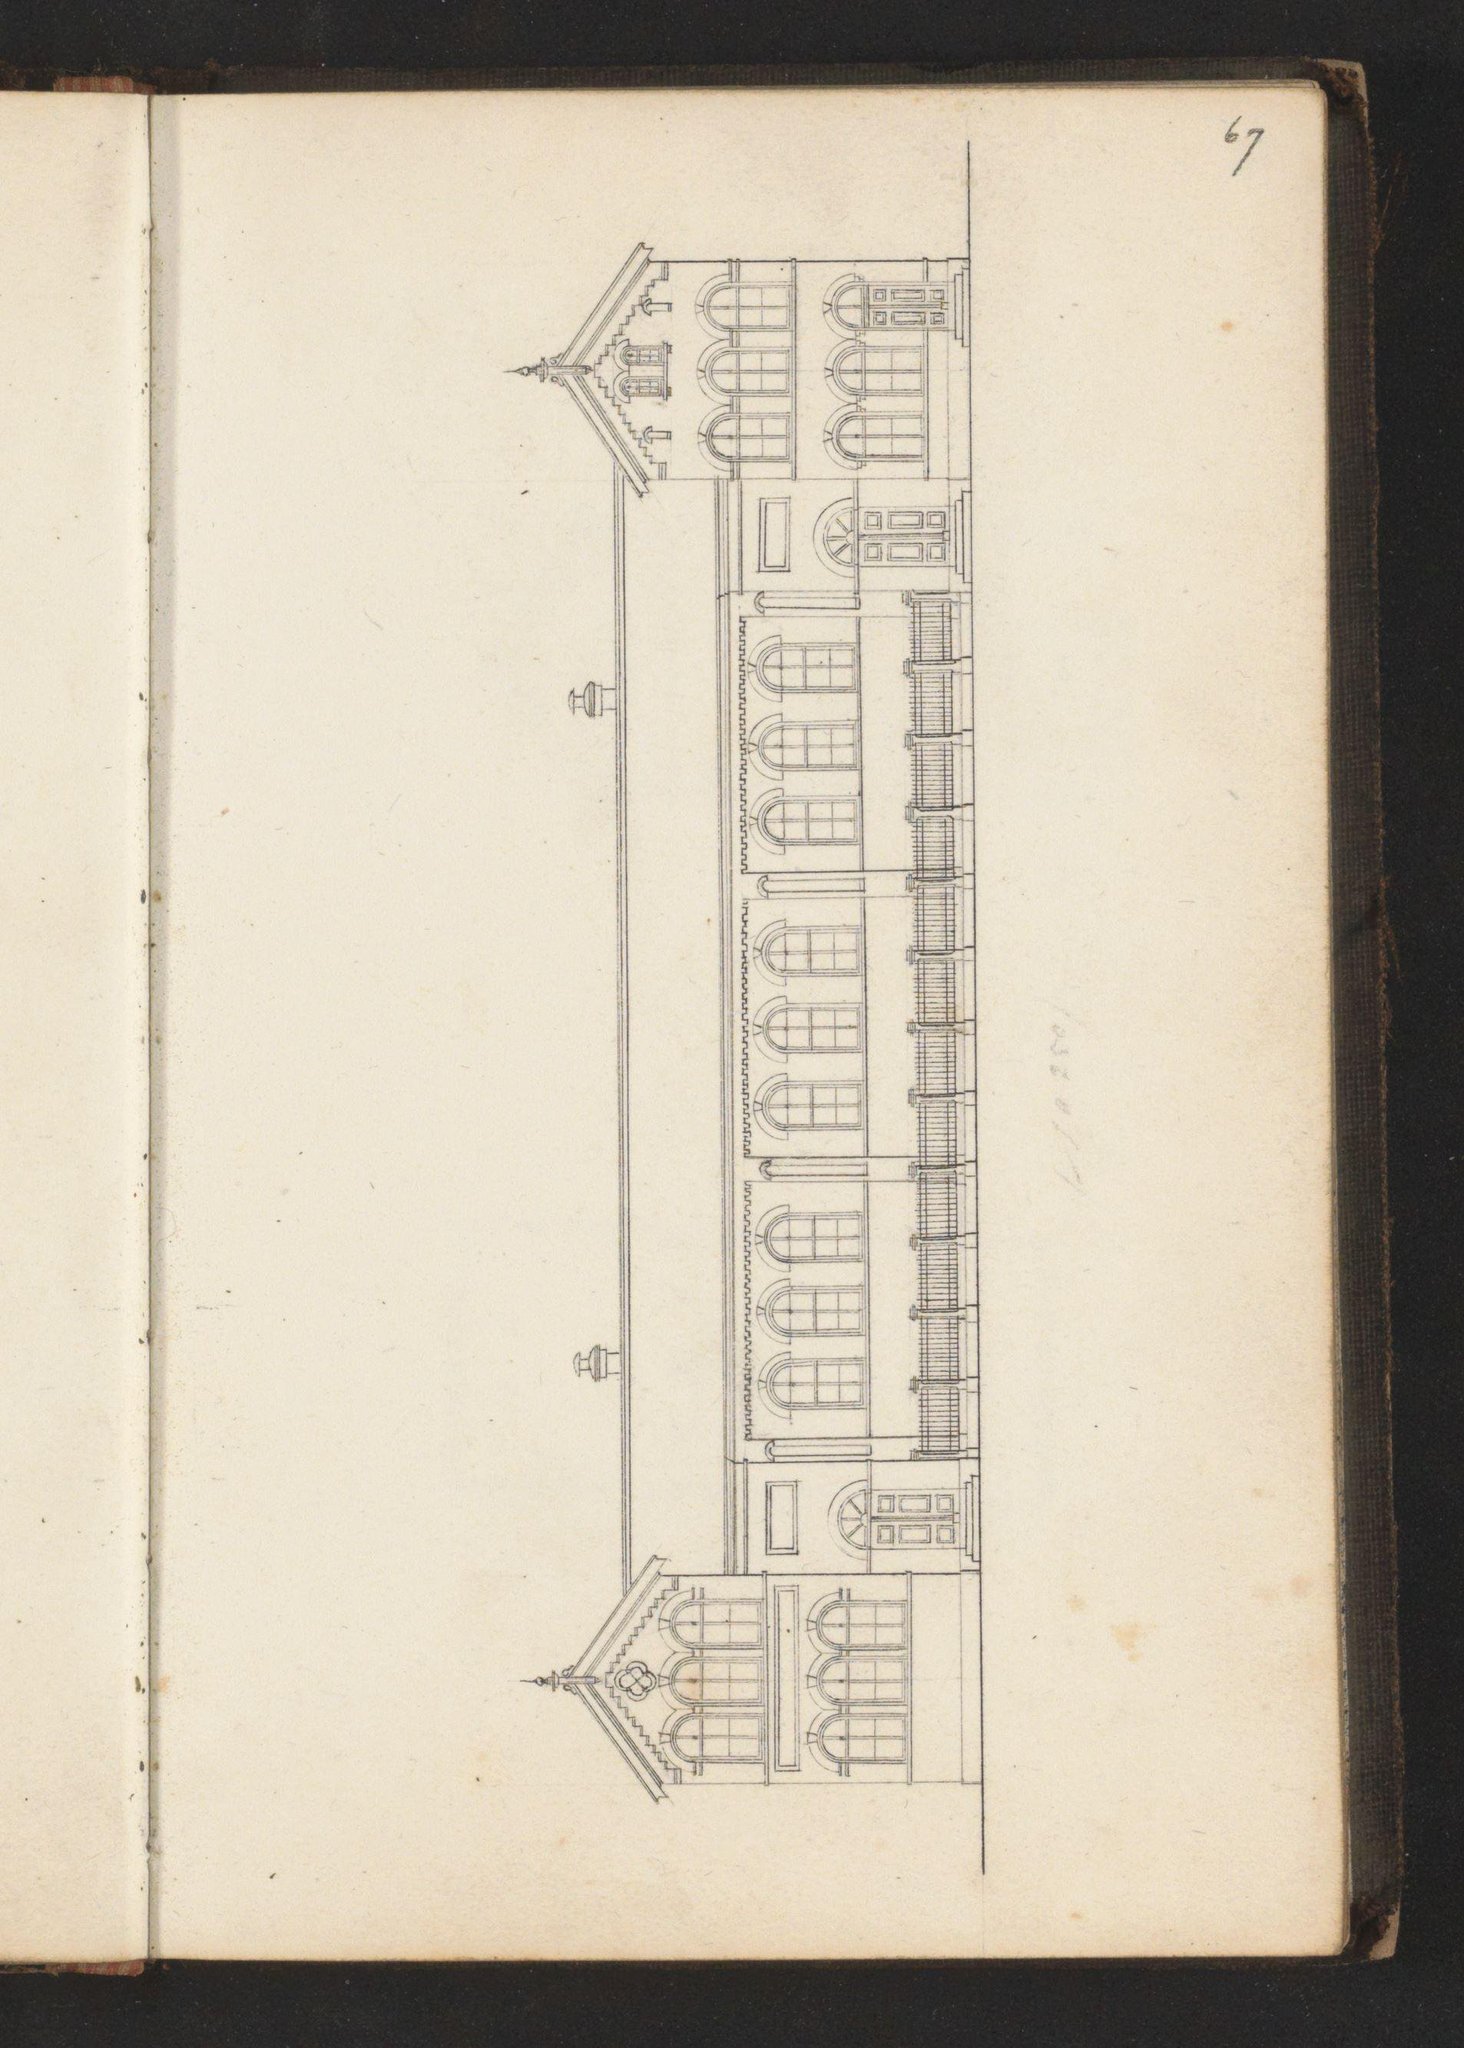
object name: sketchbook leaf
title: Opstand van de façade van een gebouw met rondboogvensters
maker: willem springer jr.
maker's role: draughtsman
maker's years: 1815-1907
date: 1864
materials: ink, paper, pencil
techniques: pen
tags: façade (of house or building)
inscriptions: annotation: ‘[...] 250 [...]’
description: Pagina 67 uit een schetsboek met 164 pagina's.